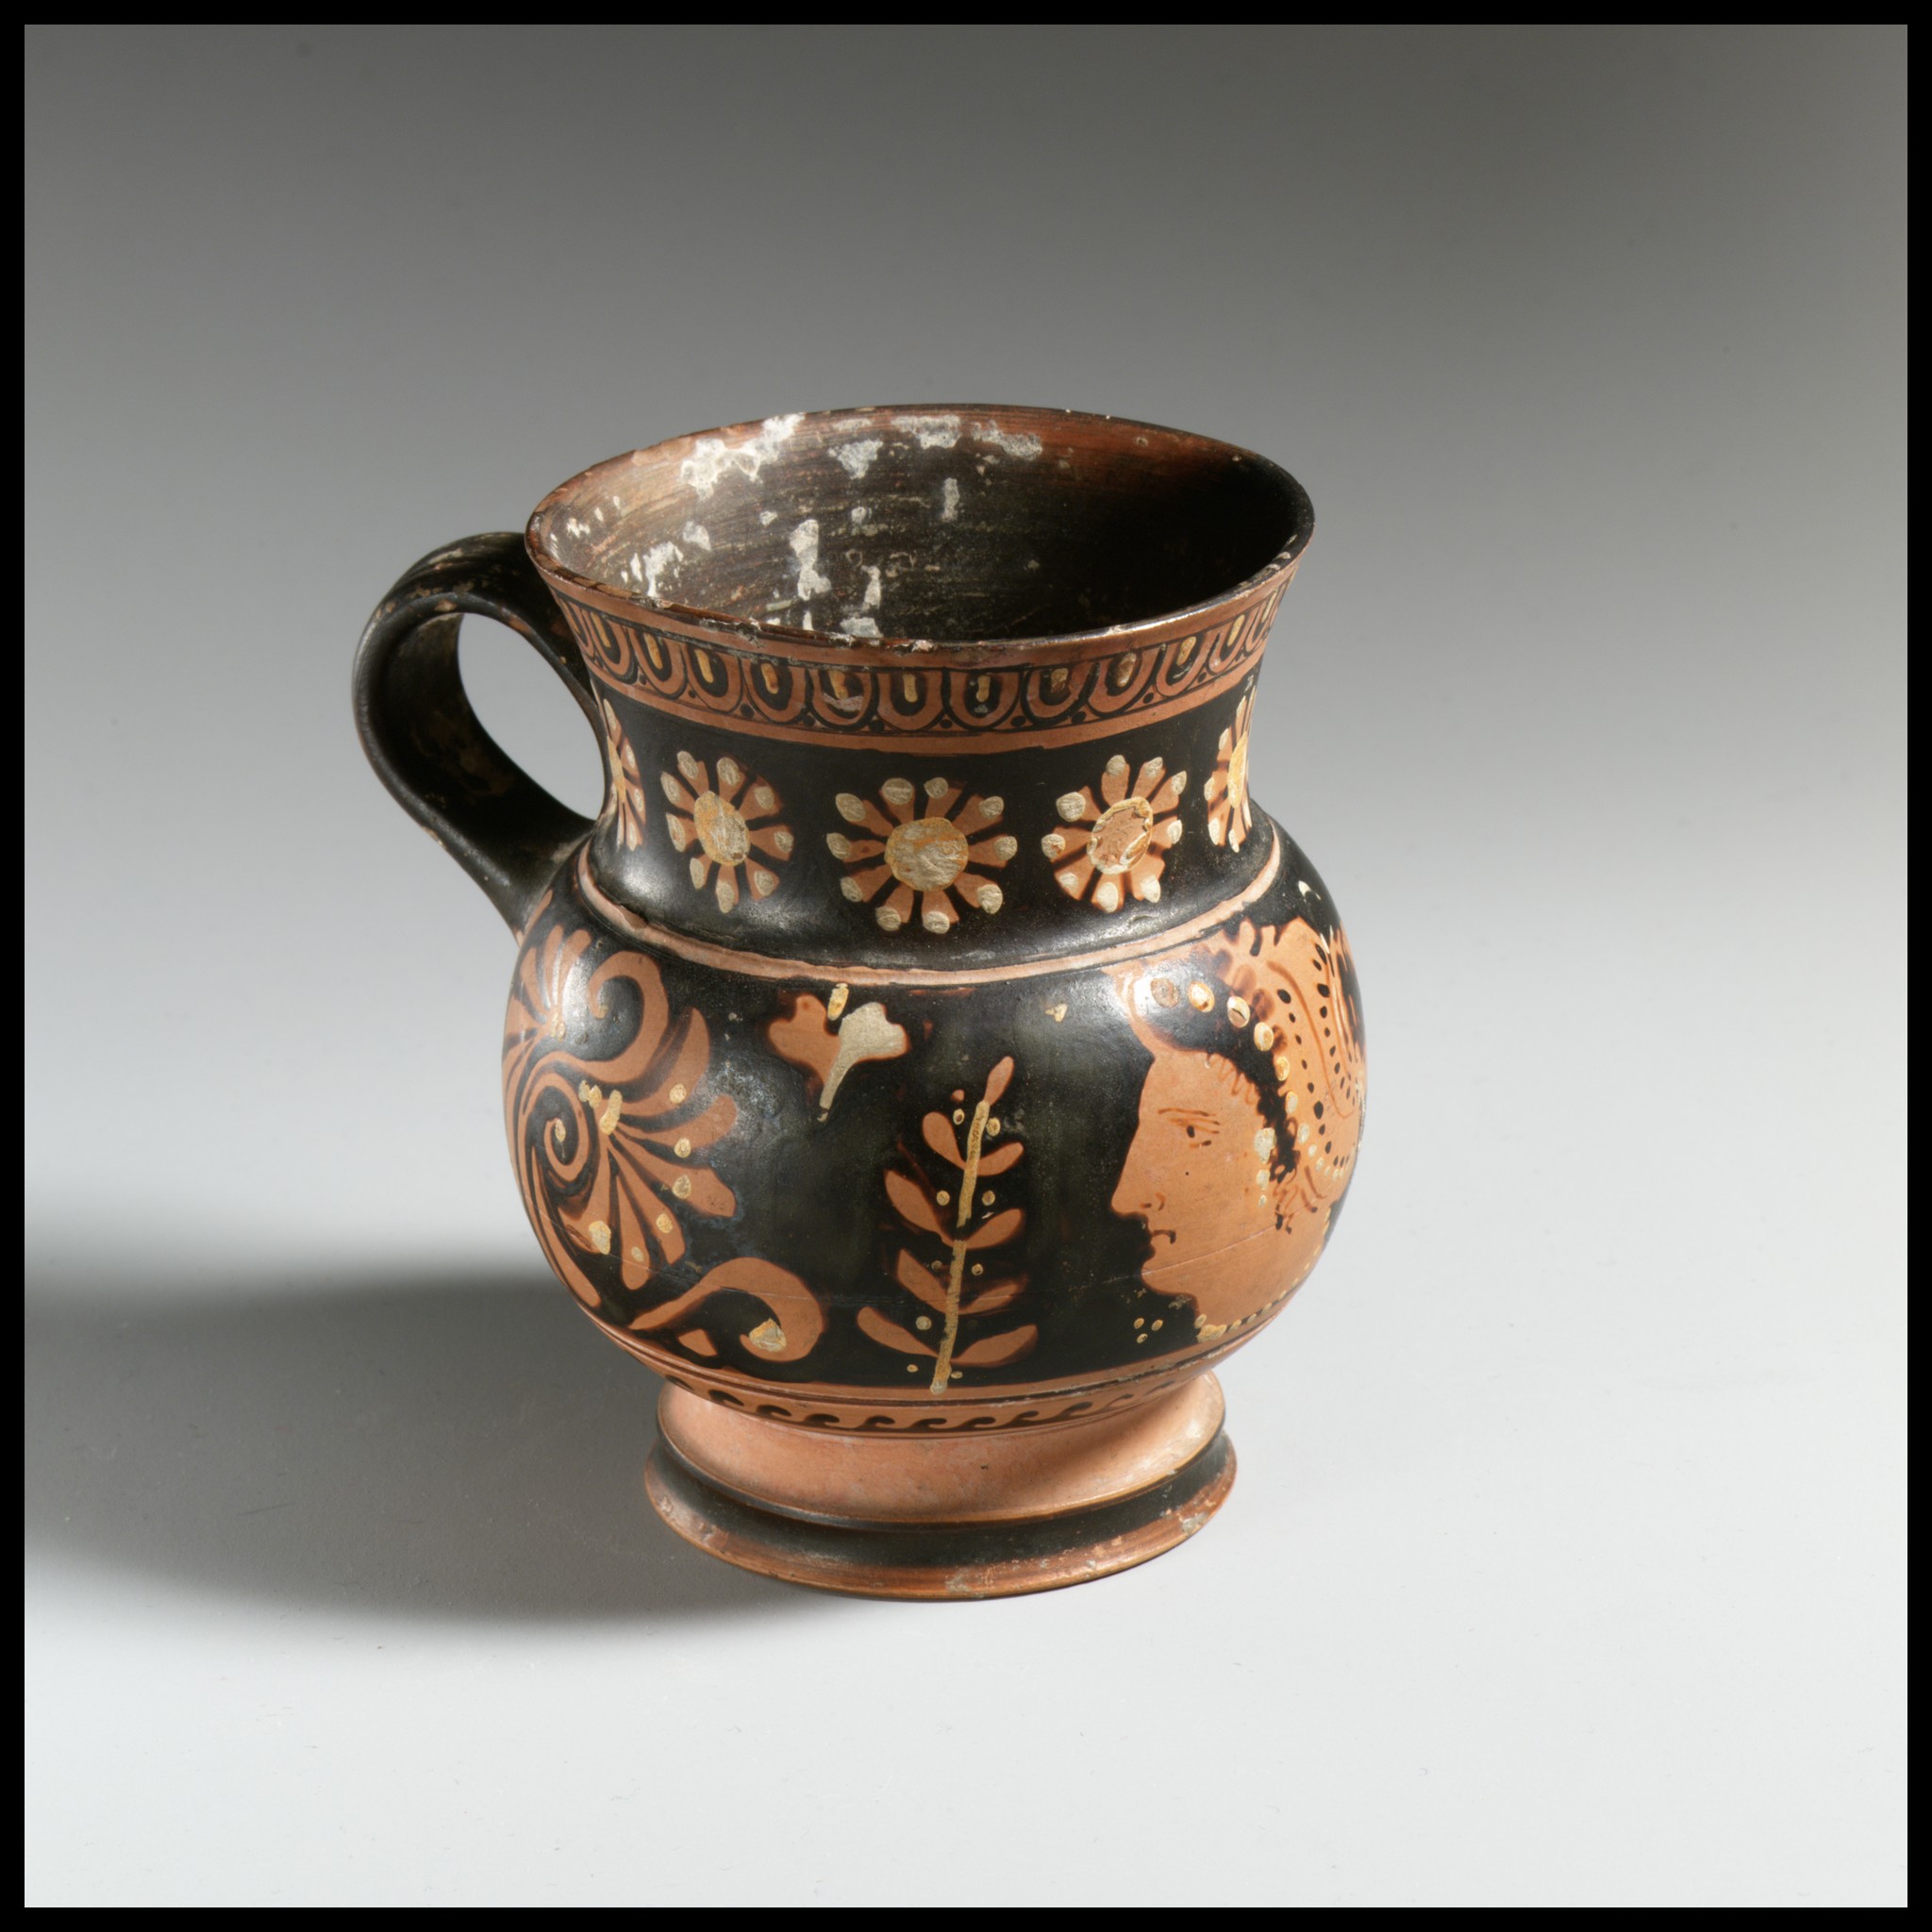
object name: mug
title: Terracotta mug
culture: greek, south italian, apulian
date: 350-325 BCE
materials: terracotta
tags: women